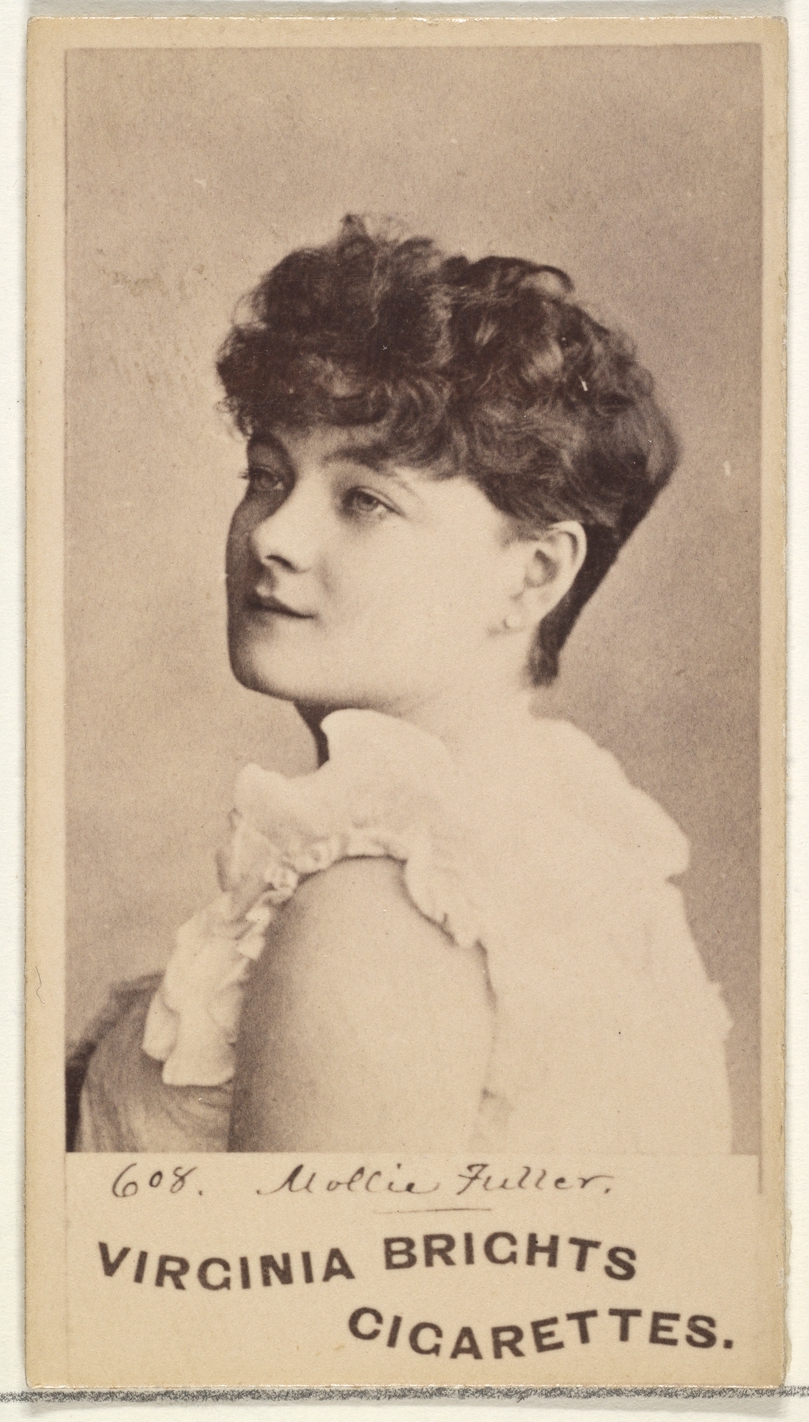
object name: photograph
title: Card 608, Mollie Fuller, from the Actors and Actresses series (N45, Type 1) for Virginia Brights Cigarettes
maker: allen & ginter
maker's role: publisher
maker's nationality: american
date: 1888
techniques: albumen silver print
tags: portraits,women,actresses